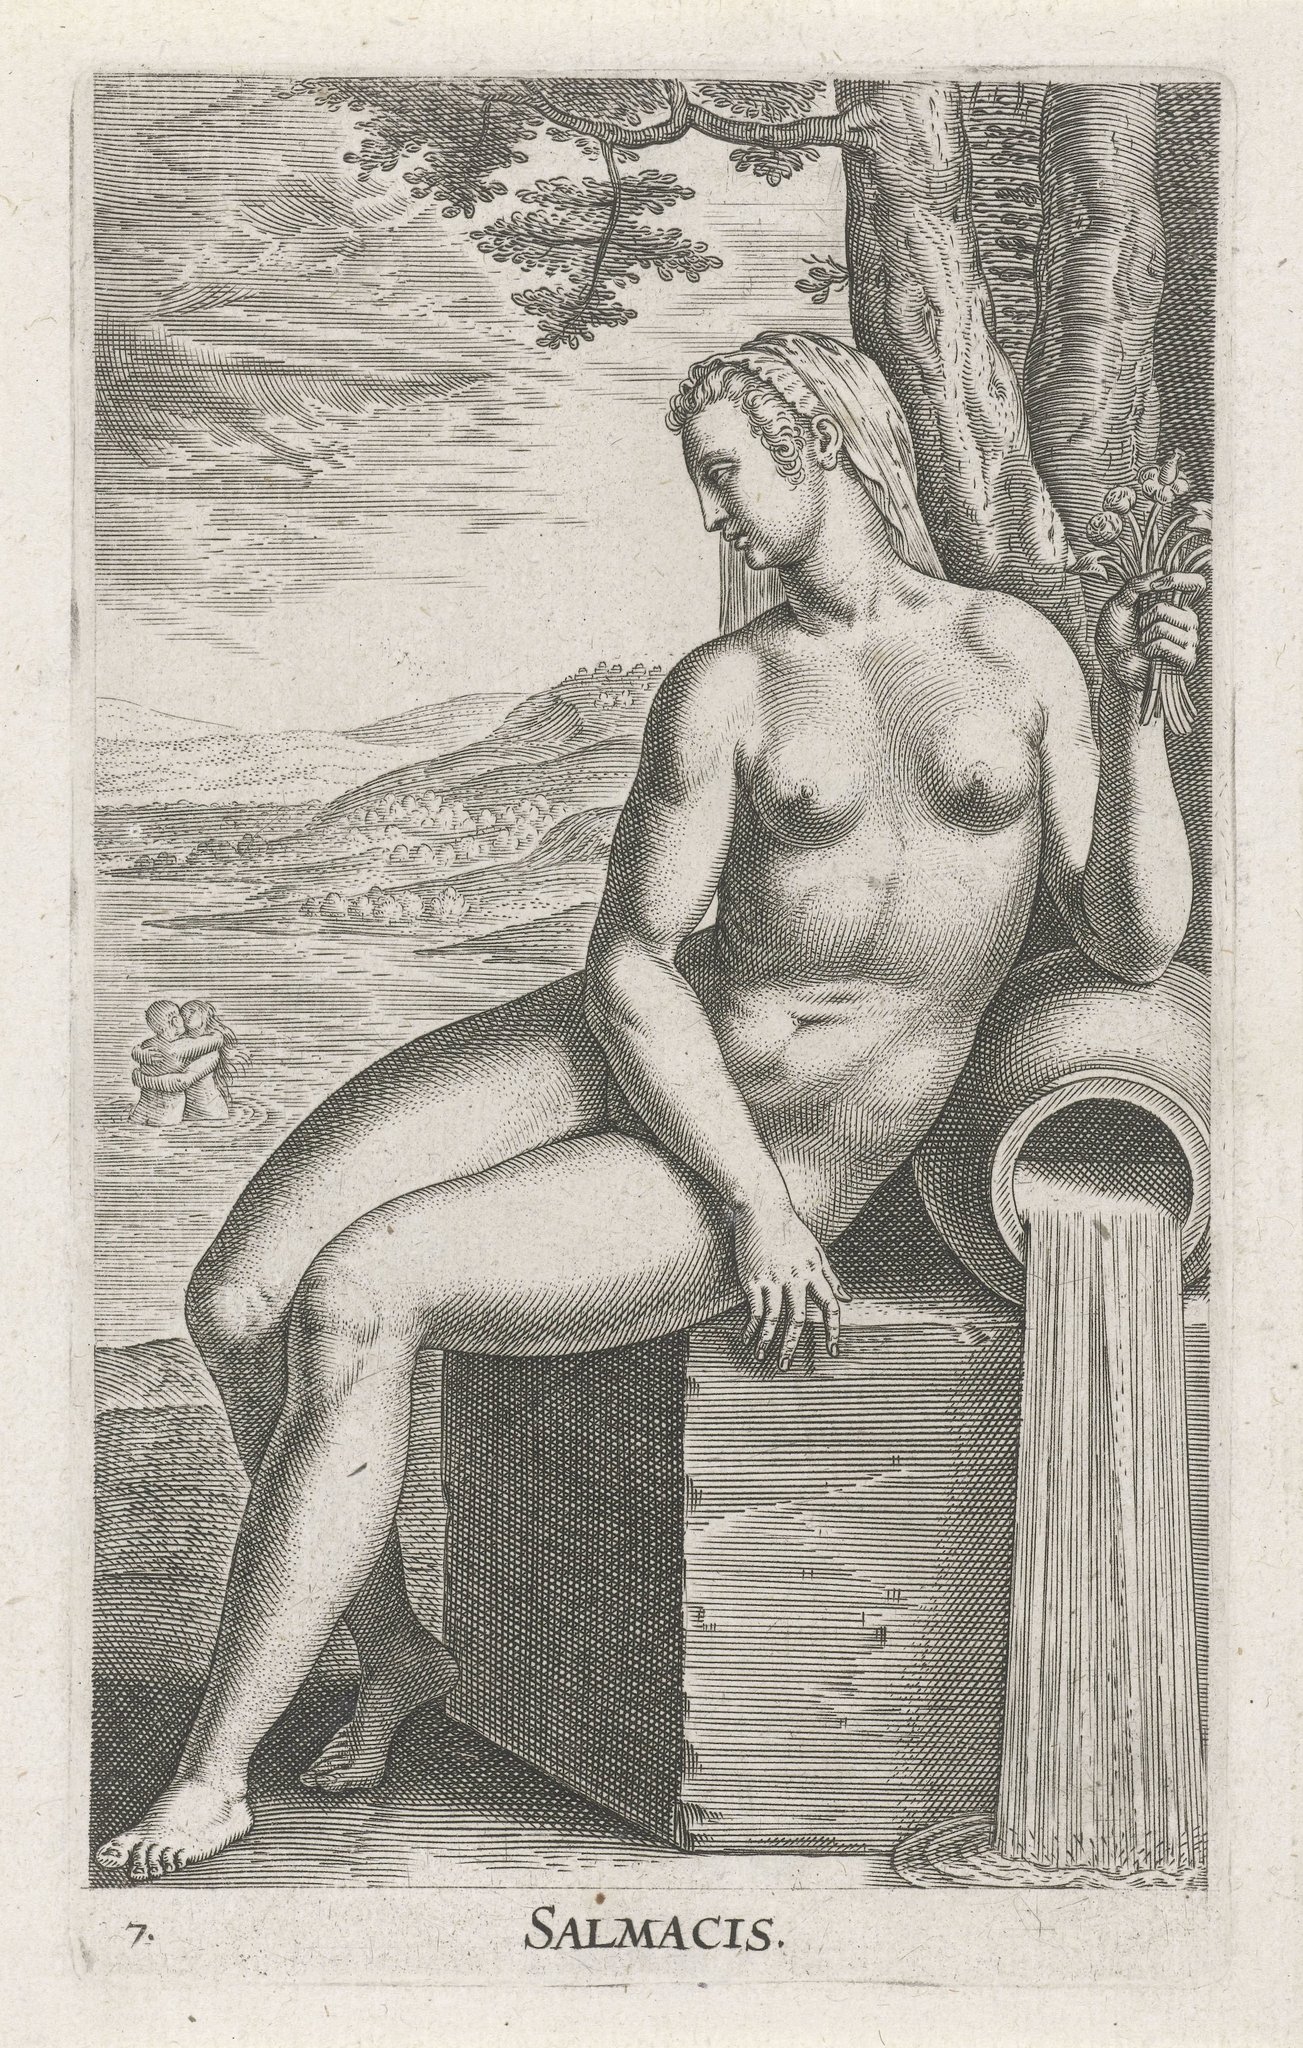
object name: print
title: Stroom- en waternimfen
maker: philips galle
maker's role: print maker, publisher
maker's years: 1537-1612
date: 1587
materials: paper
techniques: engraving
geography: antwerp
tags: story of hermaphroditus and salmacis, single named nymphs (with name), hermaphroditus and salmacis changed into a hermaphrodite: at the prayer of the fountain-nymph salmacis, who holds the bathing hermaphroditus closely embraced, their bodies fuse (ovid, metamorphoses iv 373)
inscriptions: collector's mark: Lugt 2228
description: De waternimf Salamcis, gezeten op een stenen blok. Op de achtergrond Salmacis en Hermaphroditus die elkaar in het water omhelzen, waarna ze volgens de mythe zouden versmelten tot een tweeslachtig wezen. De prent maakt deel uit van een zeventiendelige serie over stroom- en waternimfen.